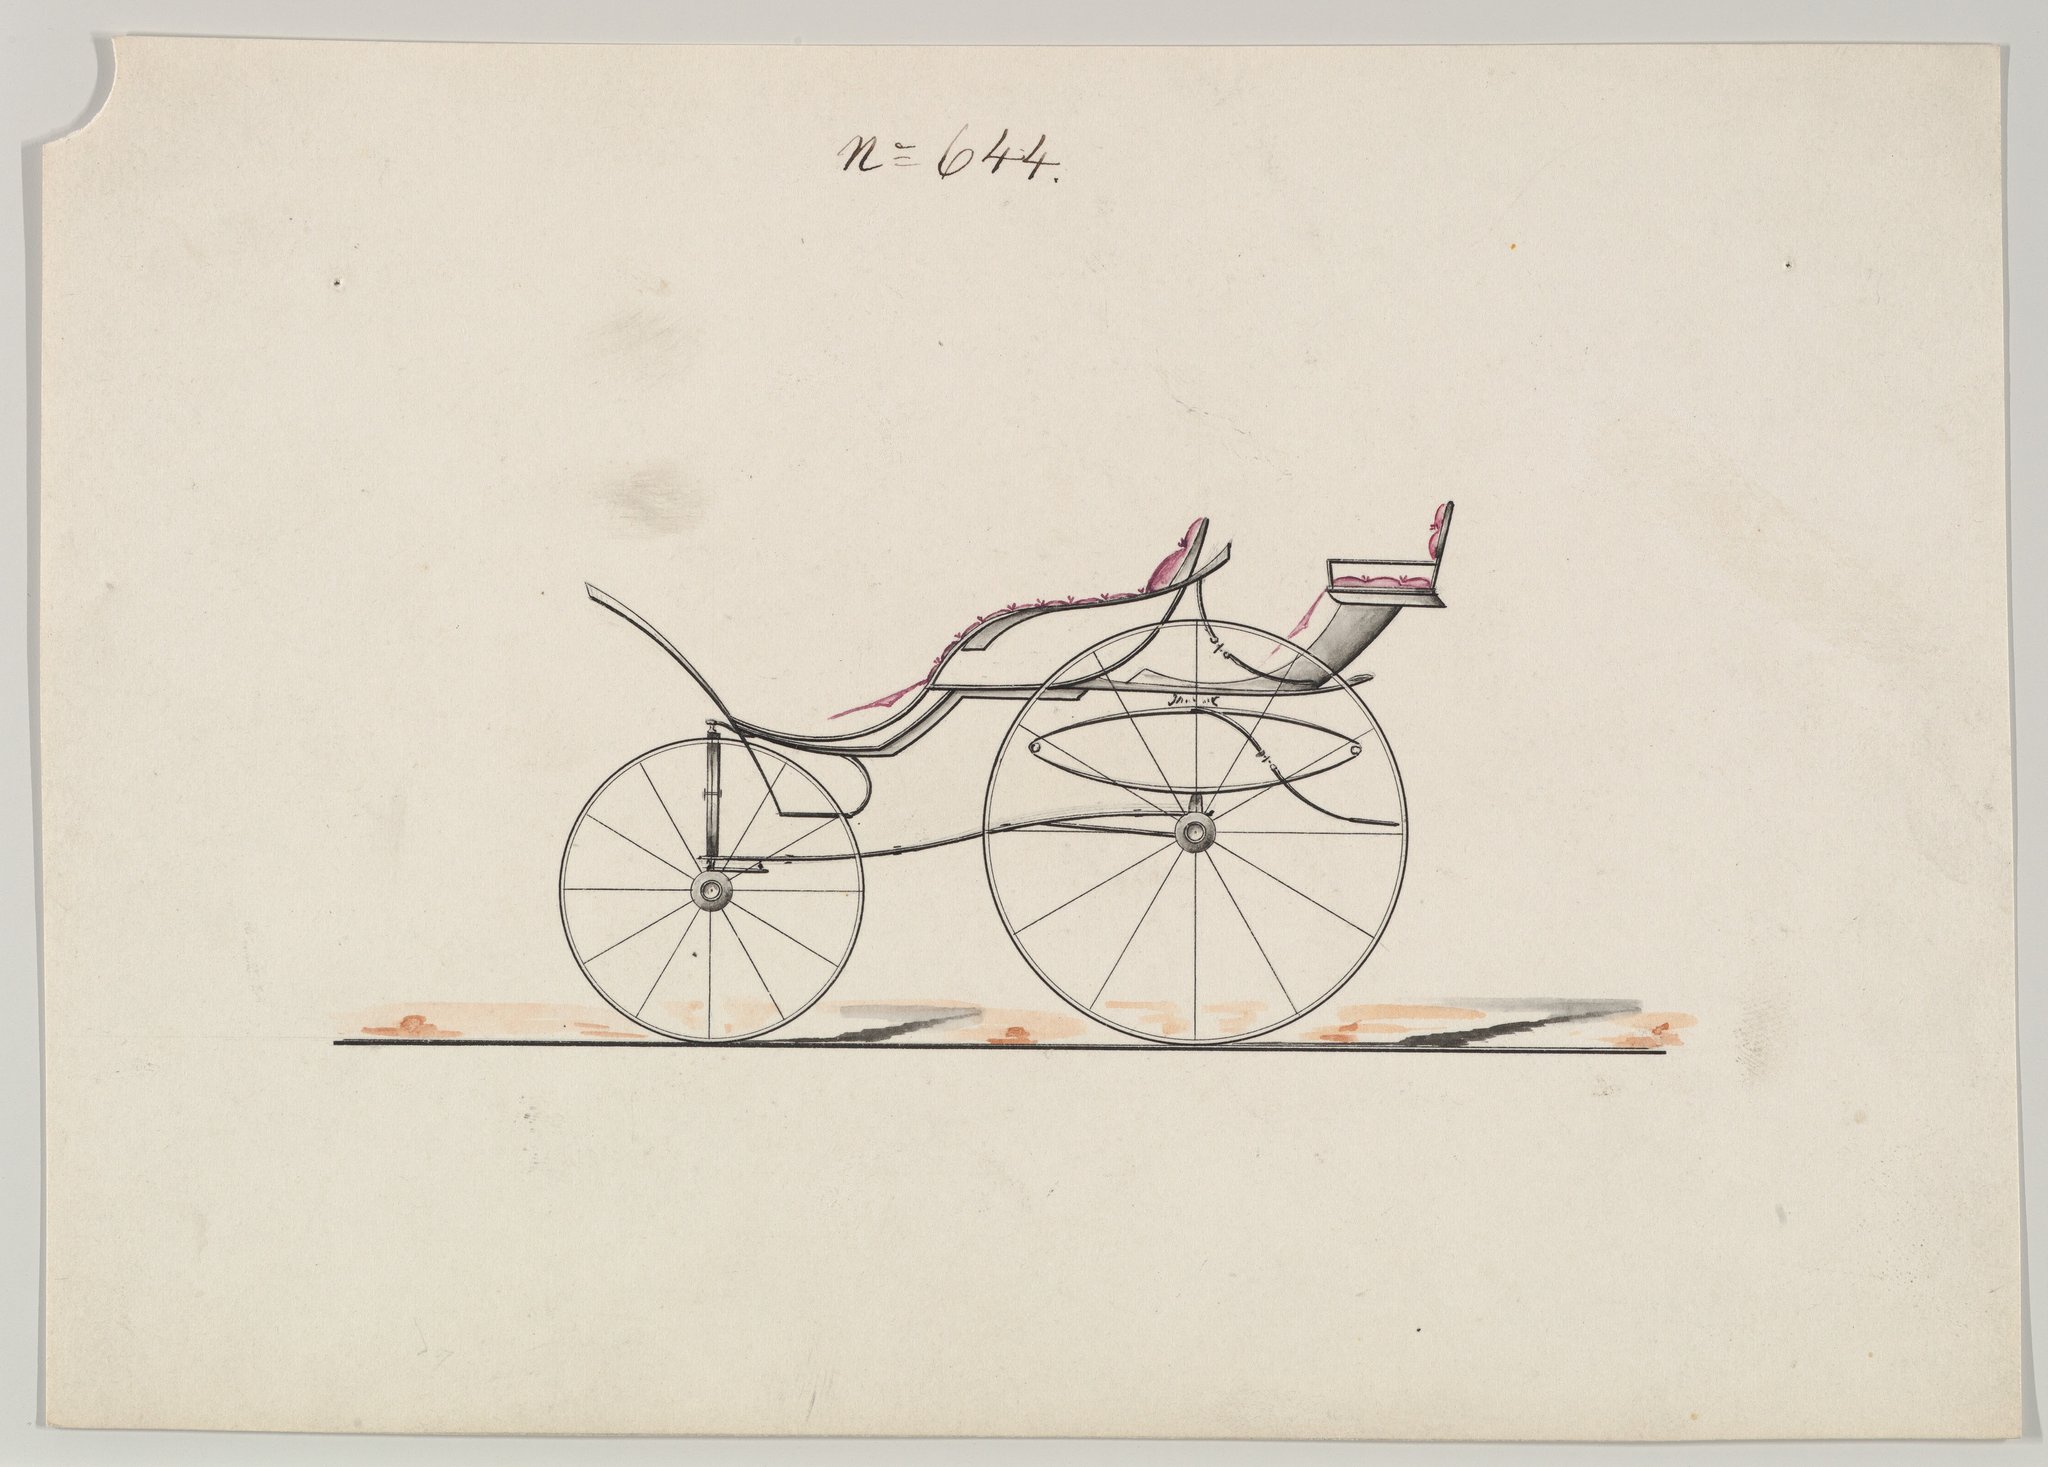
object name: drawing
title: Pony Phaeton #644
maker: brewster & co.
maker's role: manufacturer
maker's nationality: american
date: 1865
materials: gouache, ink, watercolor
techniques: pen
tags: carriages